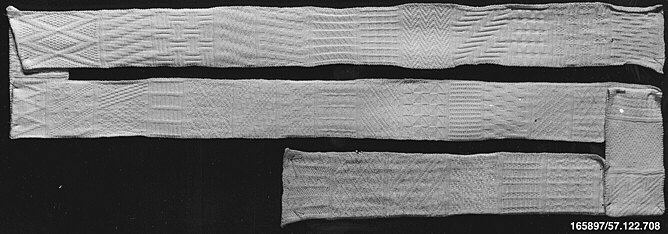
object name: sampler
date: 1801-1900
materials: lace, wool